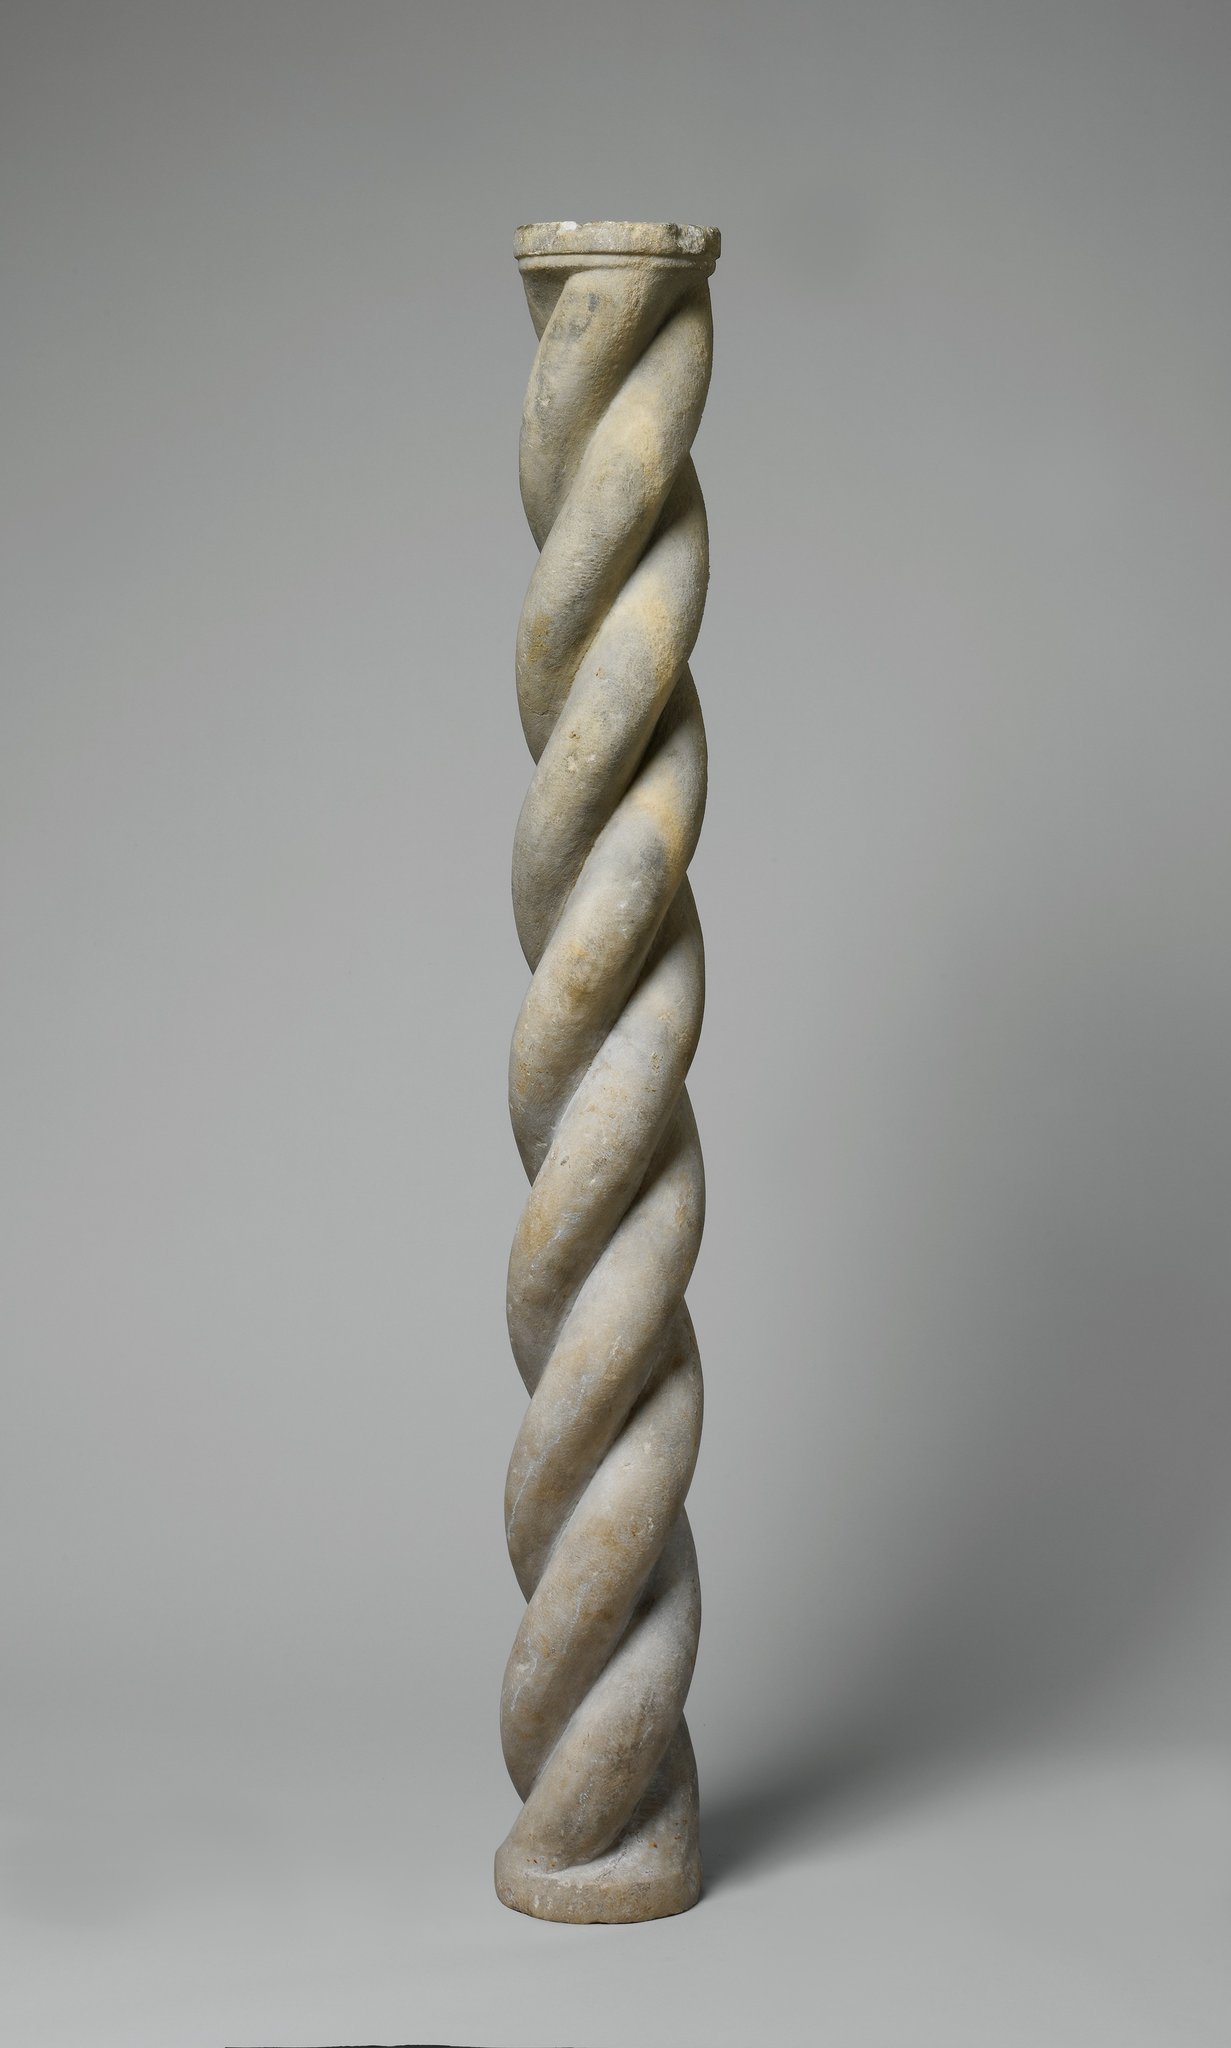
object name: shaft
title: Spiral Column Shaft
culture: italo-byzantine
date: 1201-1250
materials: marble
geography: central italy